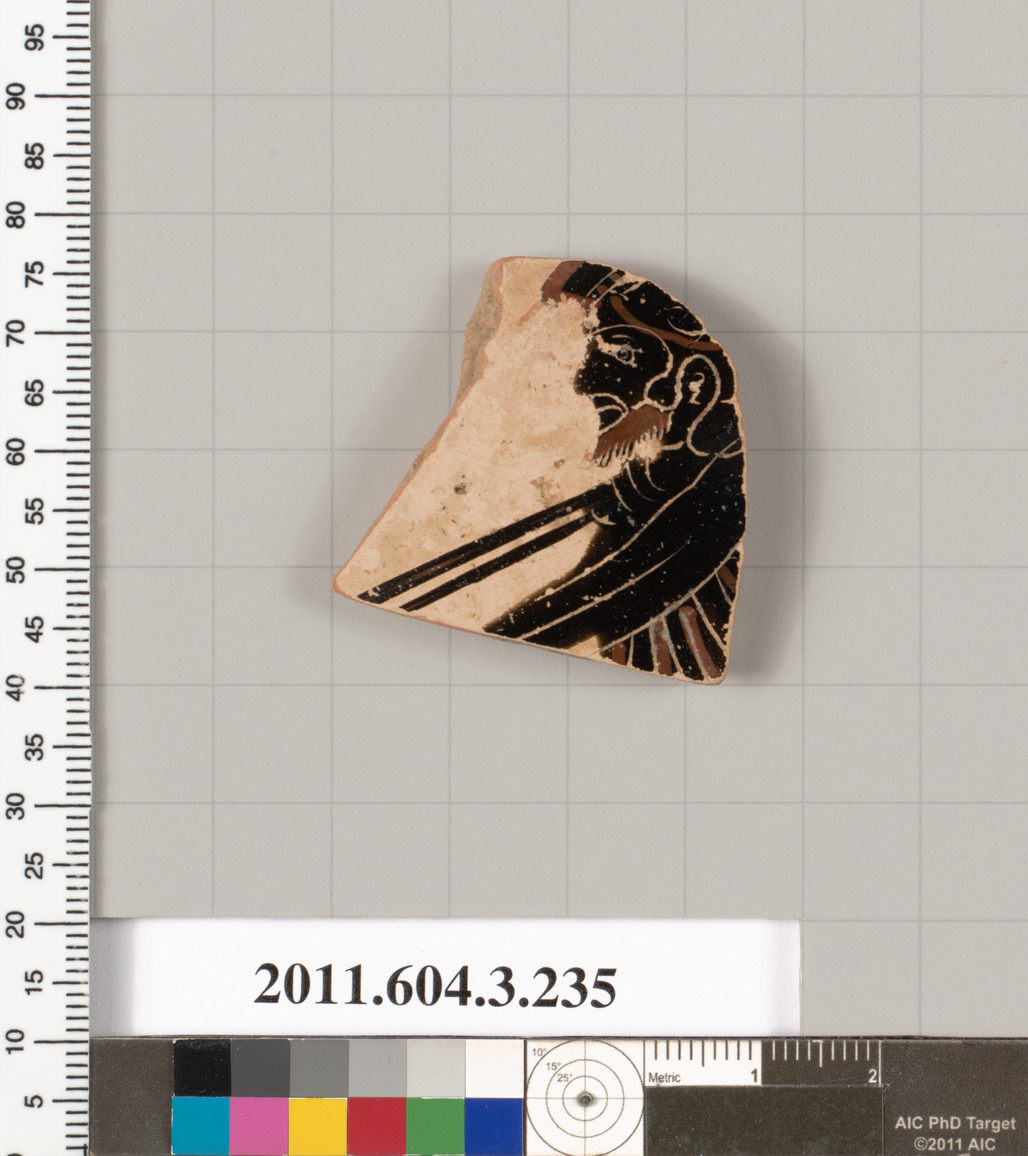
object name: neck amphora fragment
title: Terracotta fragment of a neck-amphora (jar)?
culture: greek, attic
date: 534-468 BCE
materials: terracotta